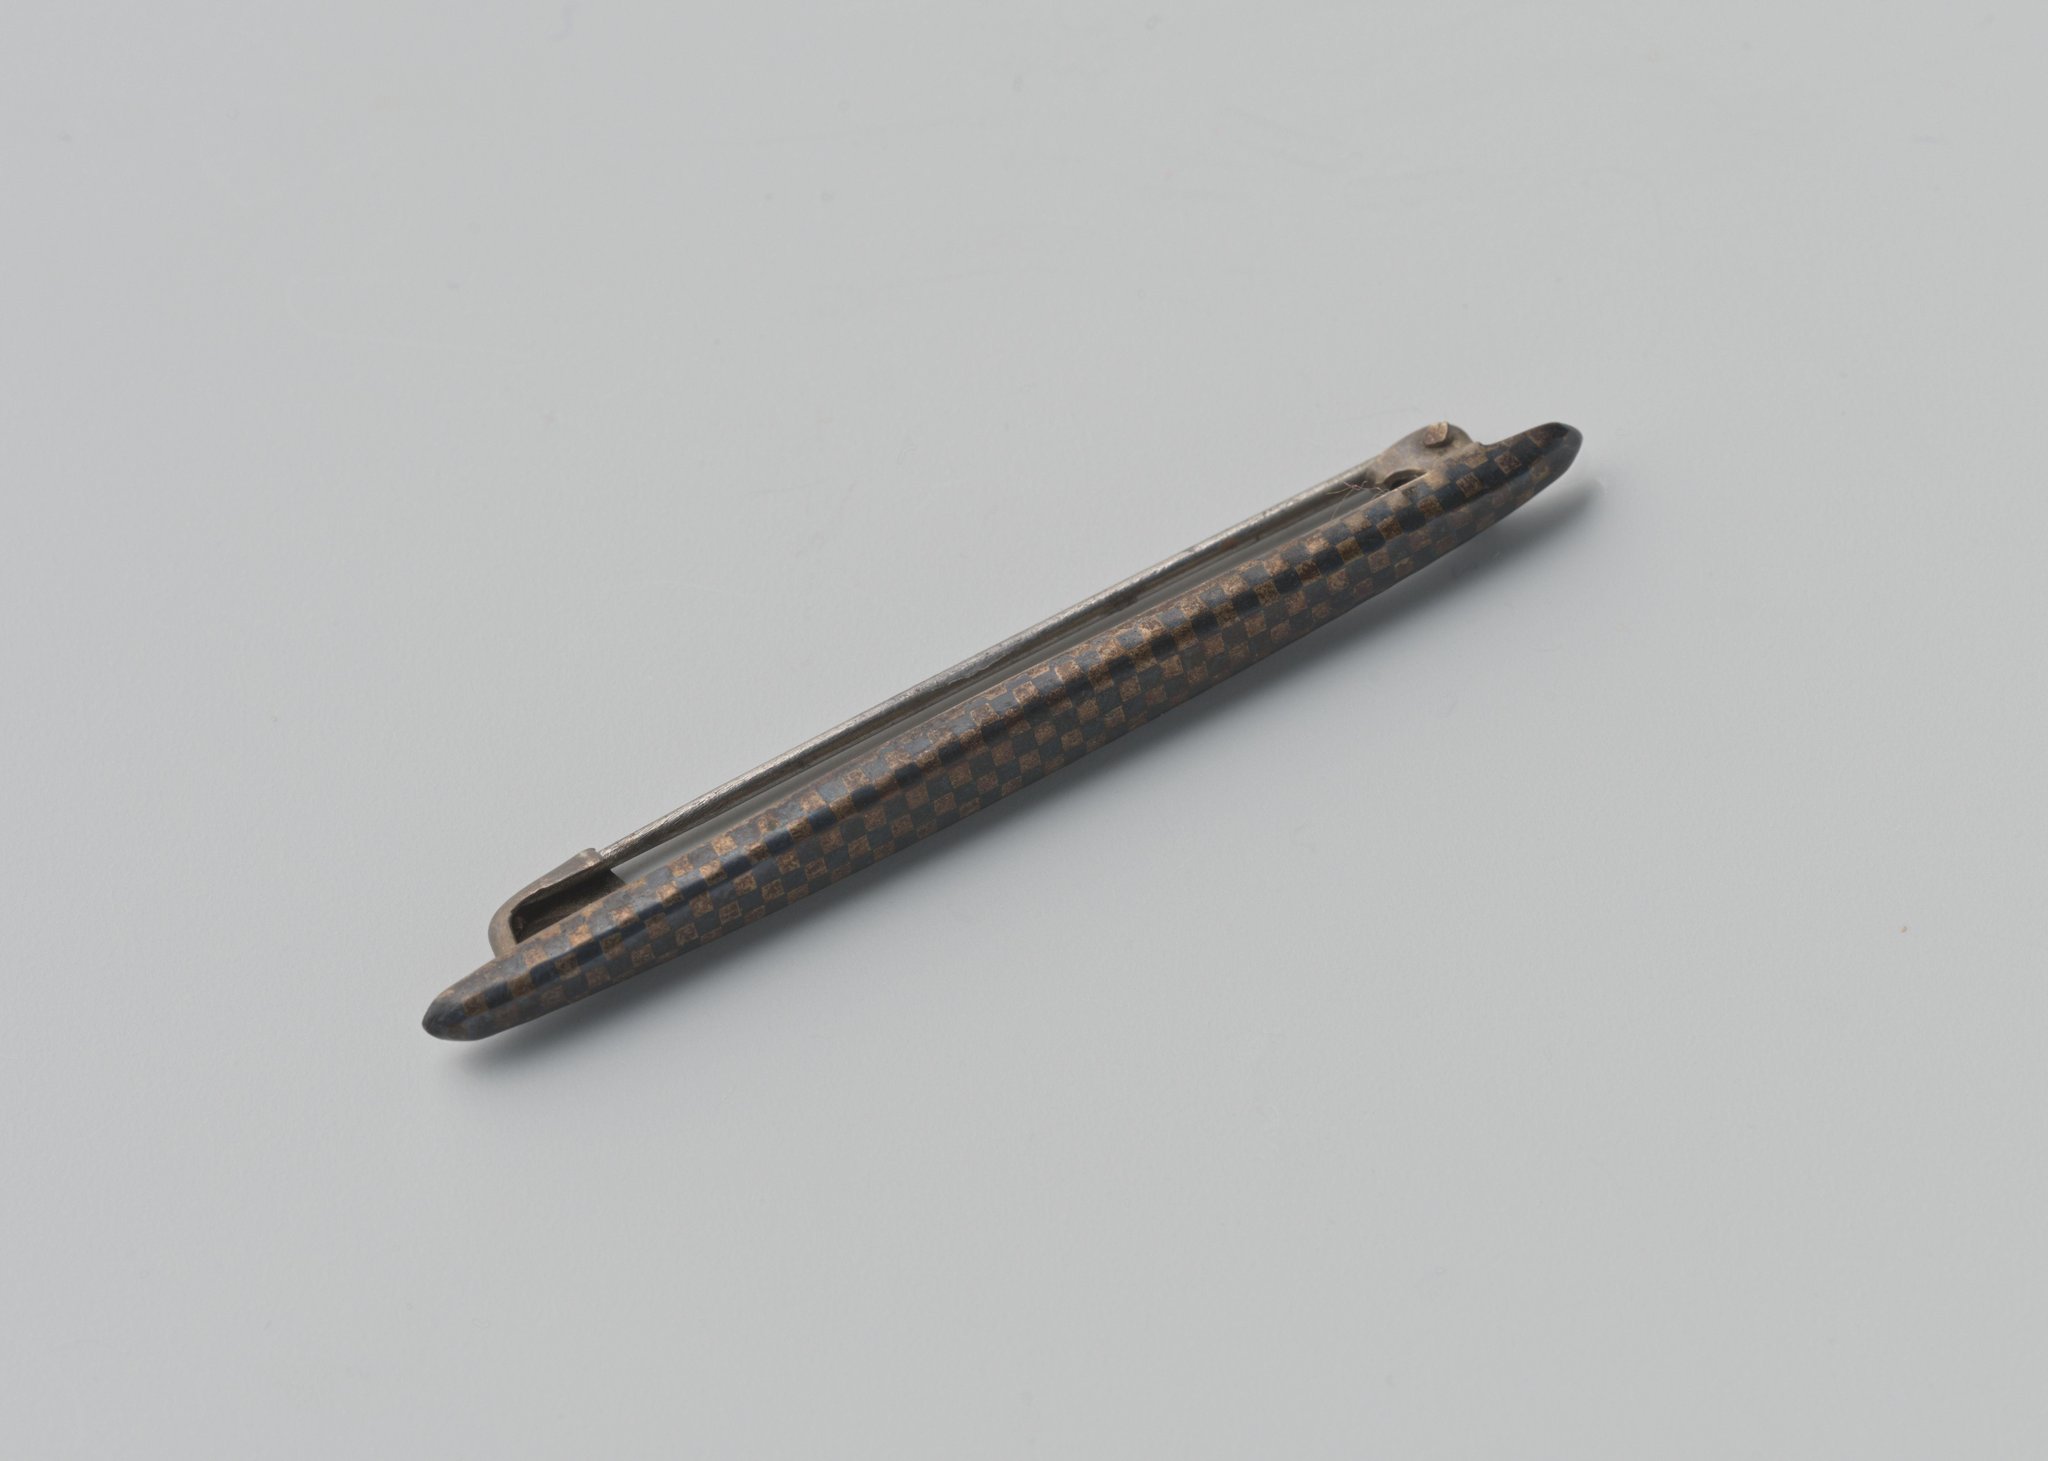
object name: pin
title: Speld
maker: Anonymous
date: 1900-1925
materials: metal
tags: eugen wachenheimer, else wachenheimer-moos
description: Dit object is onderdeel van de nalatenschap van Isabel Elon-Wachenheimer (1928-2010). Tot haar overlijden behoorde het samen met de andere objecten uit de nalatenschap tot haar privédomein van Isabel Wachenheimer. In die particuliere context zijn deze objecten tezamen en individueel aandenkens - aan de jeugd, ouders en familie van Isabel Wachenheimer vóór en tijdens de Shoah en aan haar leven na de Tweede Wereldoorlog. Isabel Wachenheimer, die van juni 1943 tot mei 1945 gevangen zat in Kamp Westerbork, Theresienstadt, Auschwitz, Lenzing a/d Oberdonau (een buitenkamp van Mauthausen), overleefde de Shoah. Haar ouders – Eugène Wachenheimer en Else Wachenheimer-Moos - werden op 14 oktober 1944 in Auschwitz-Birkenau vermoord.